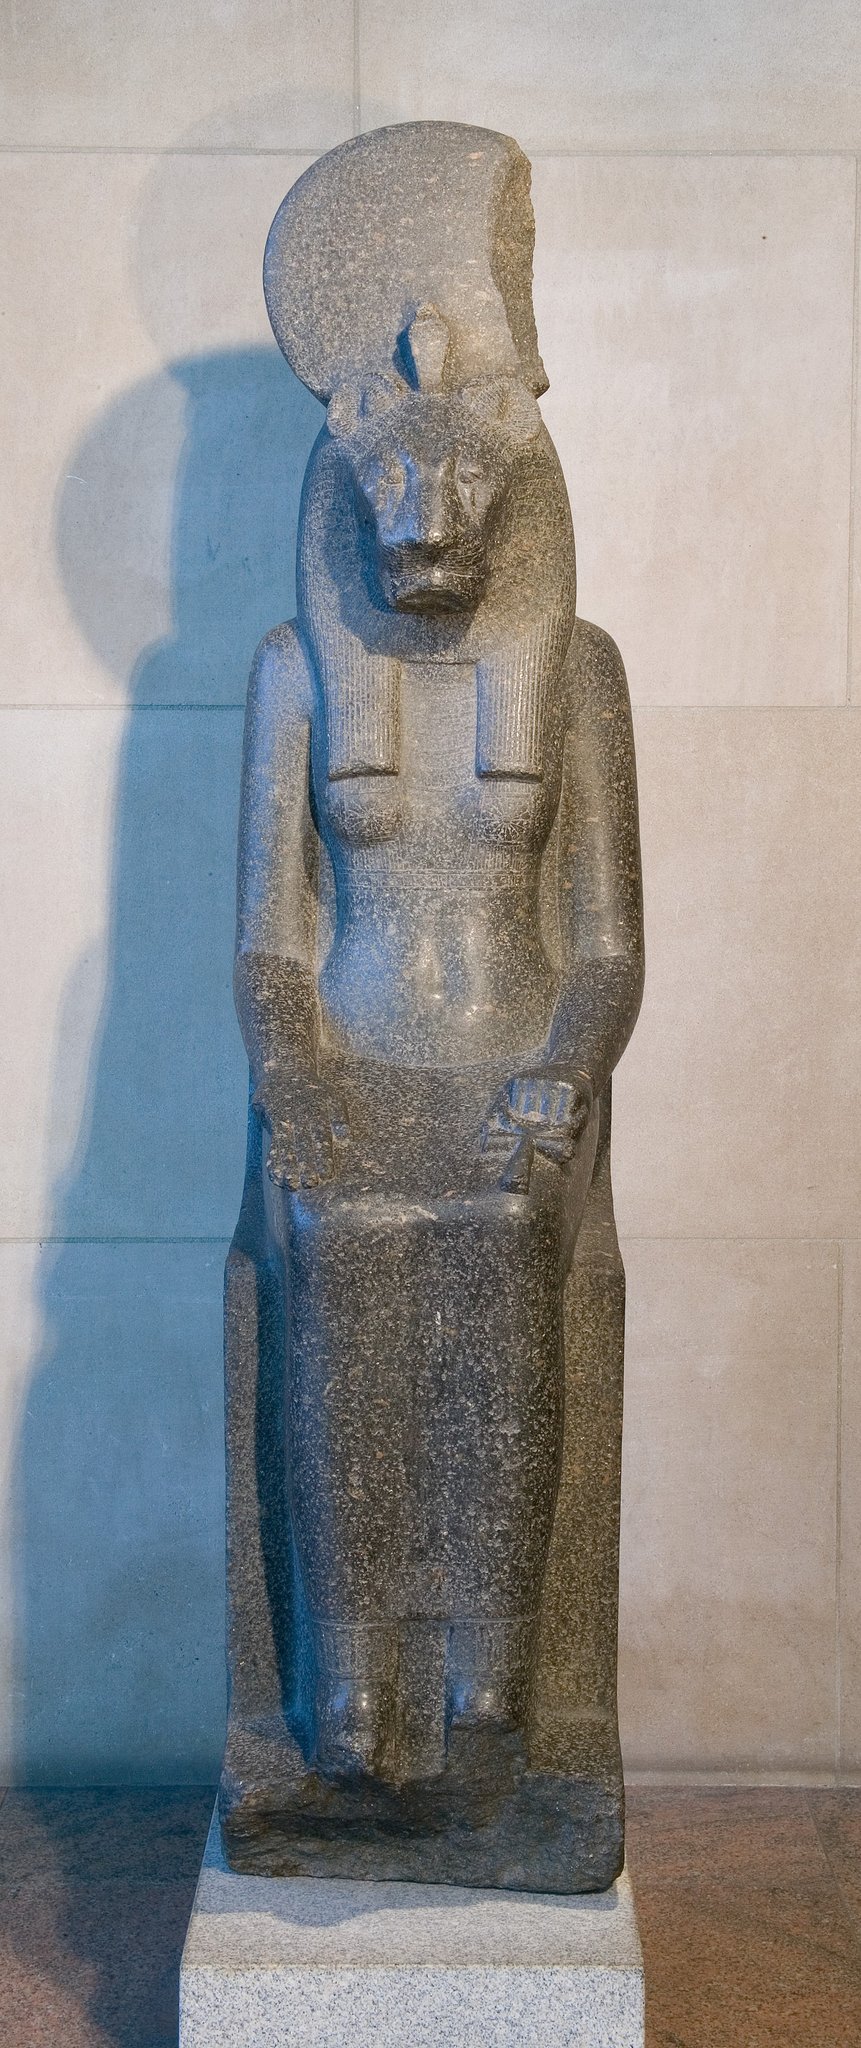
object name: statue, sakhmet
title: Statue of the Goddess Sakhmet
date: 1390-1352 BCE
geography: egypt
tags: goddess